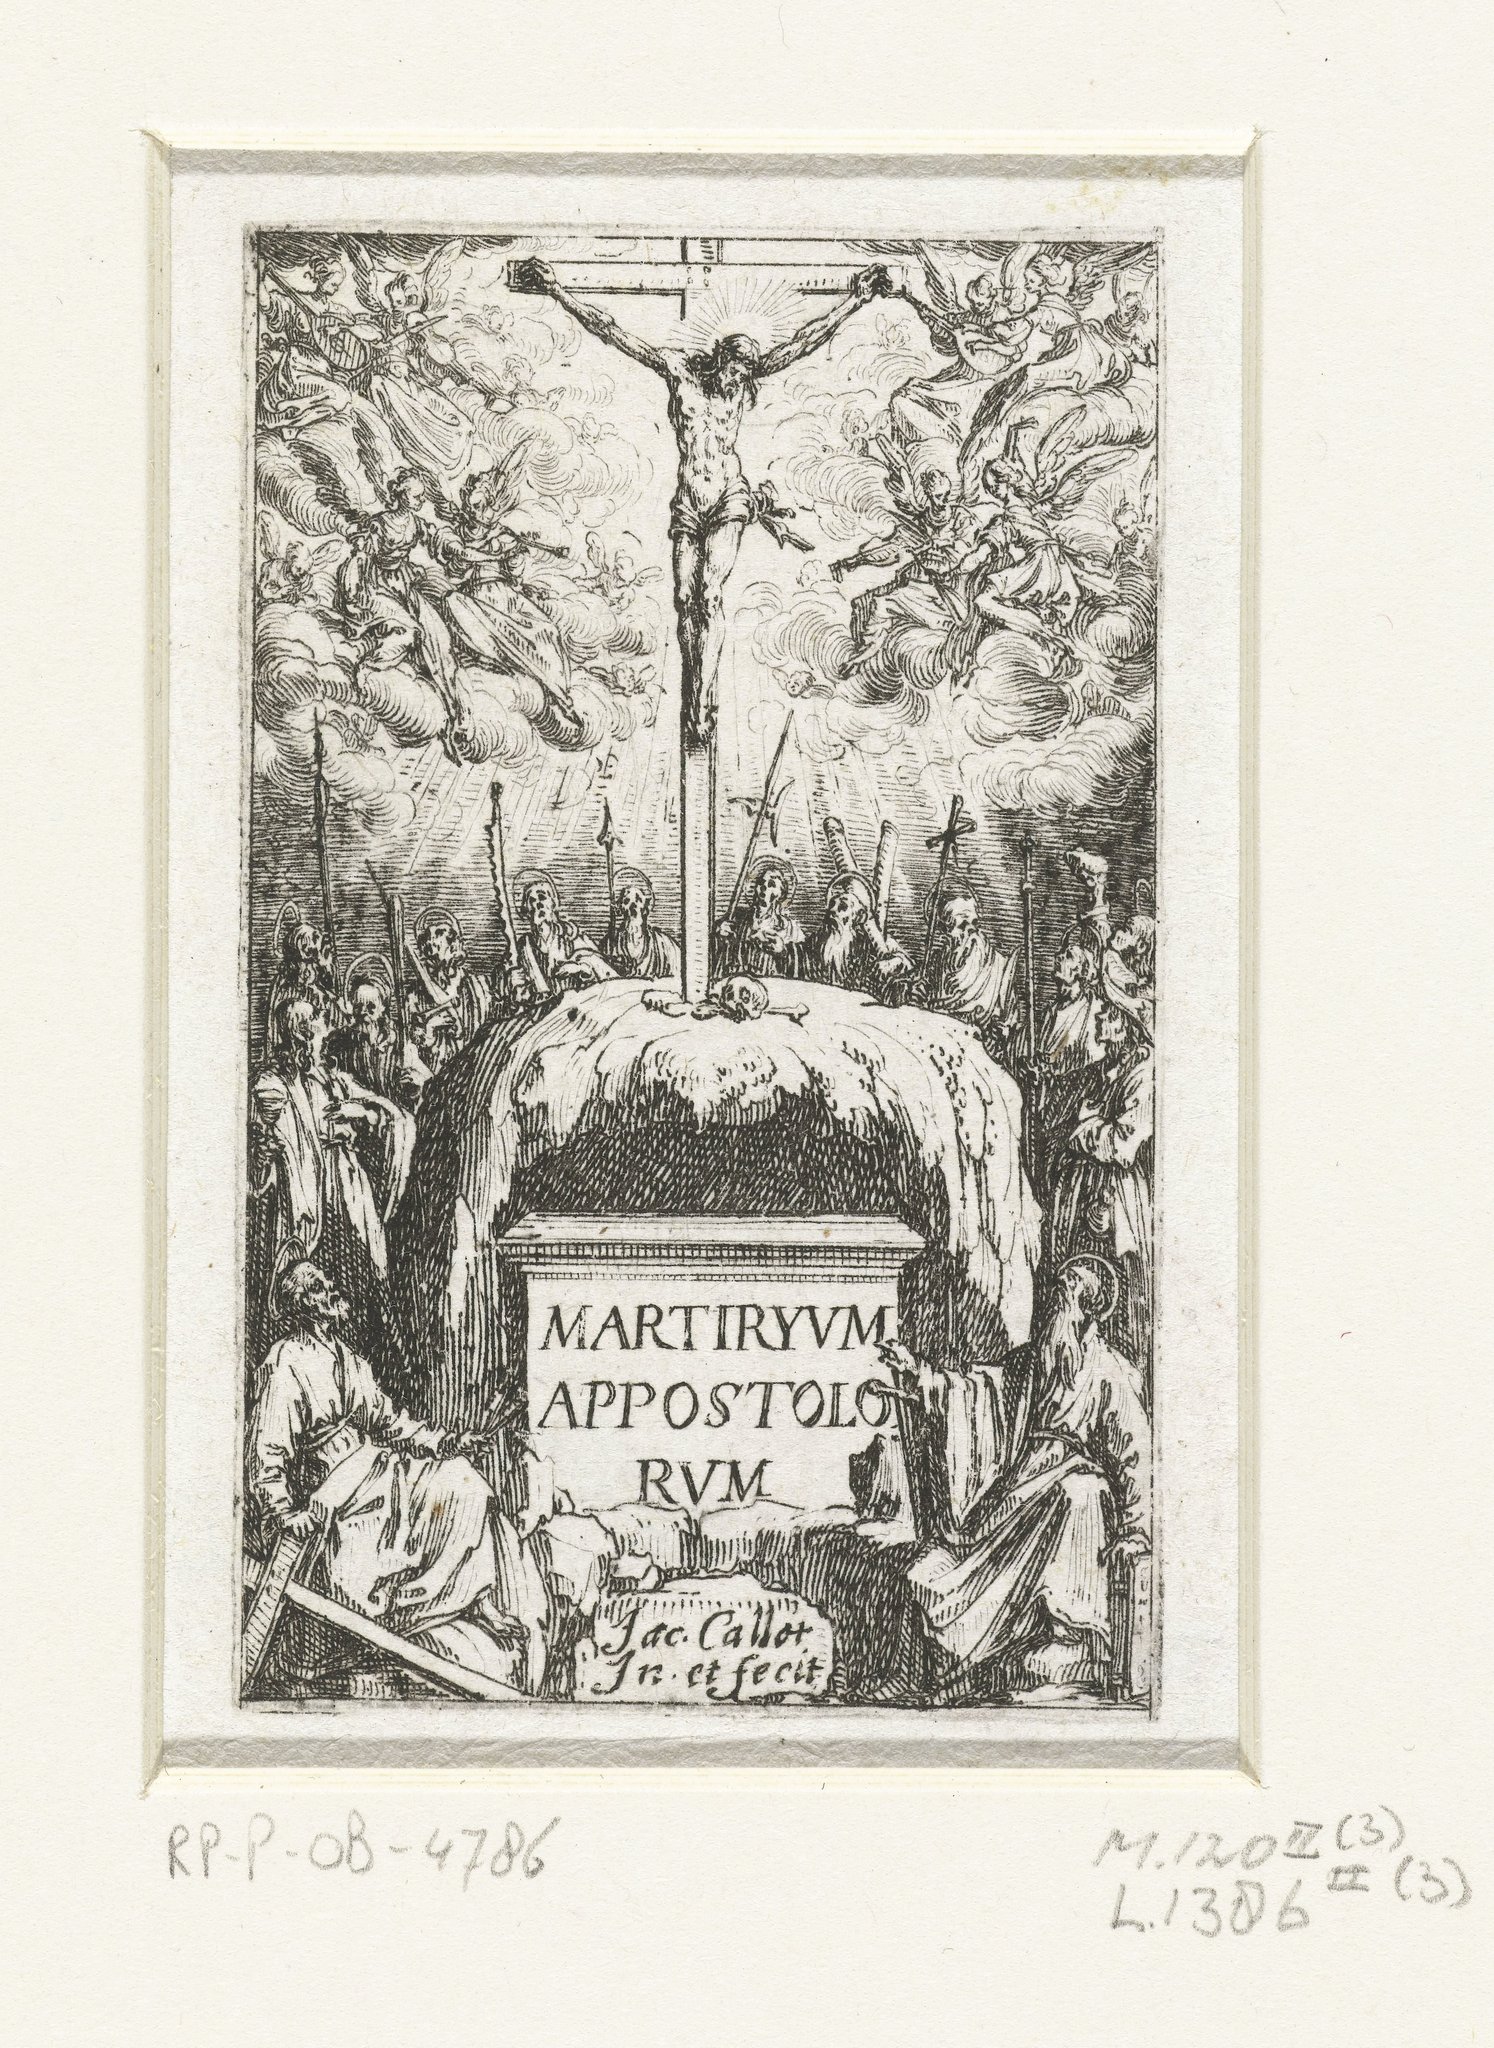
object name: print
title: De kleine apostelen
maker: jacques callot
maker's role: draughtsman, print maker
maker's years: 1592-1635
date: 1632-1634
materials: paper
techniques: etching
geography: nancy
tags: the twelve apostles (as a group), usually with books or scrolls (not in biblical context), crucified christ with other persons, angels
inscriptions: collector's mark: Lugt 240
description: De kruisigde Christus te midden van musicerende engelen en de apostelen. Laatstgenoemden dragen elk een attribuut dat herinnert aan hun marteldood. Deze prent is het titelblad voor een reeks van 15 prenten van de martelingen die de apostelen hebben ondergaan.